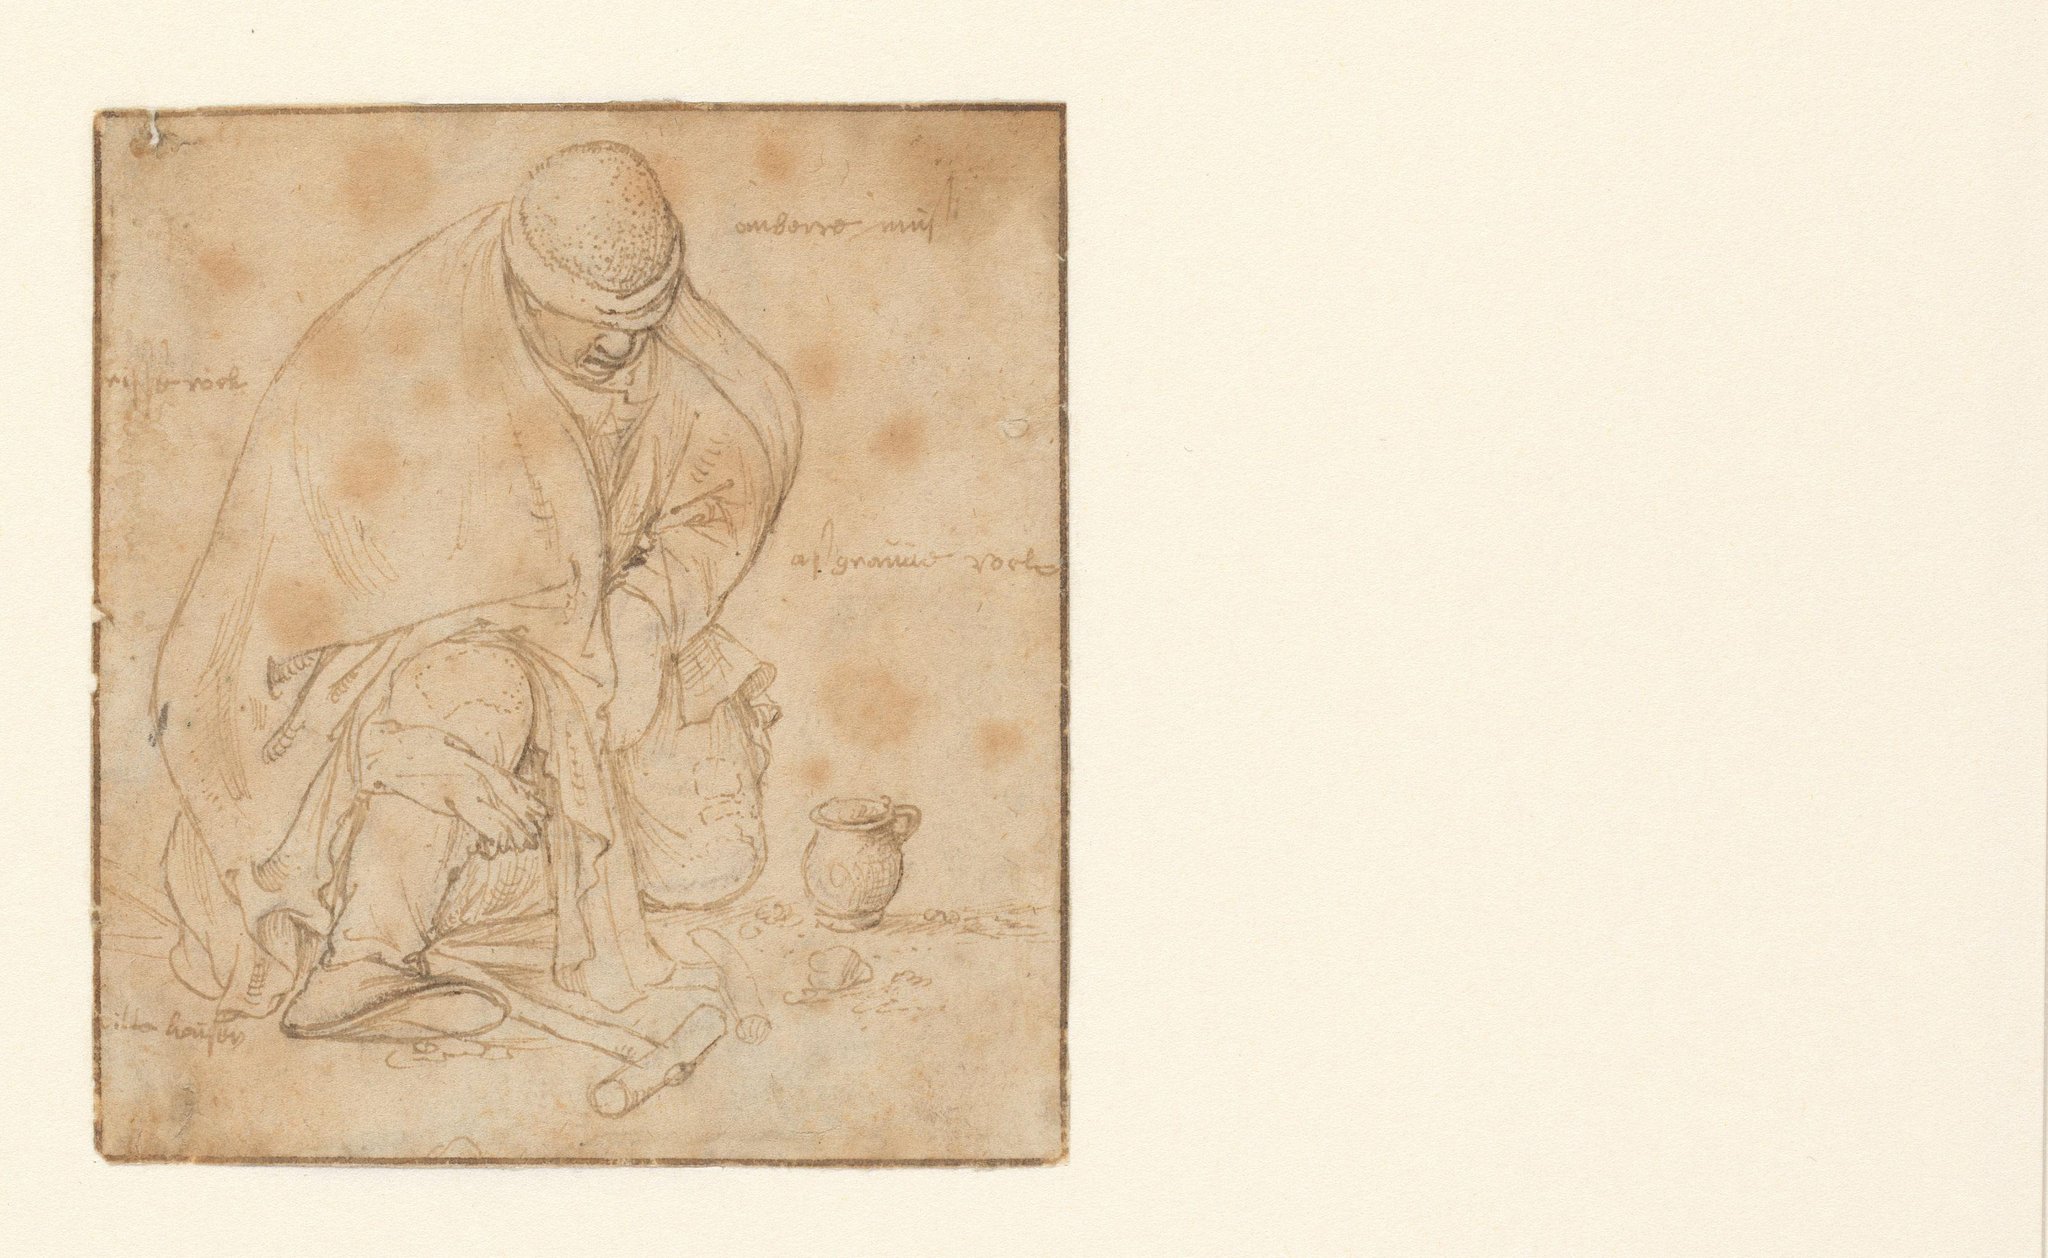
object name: drawing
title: Zittende bedelaar, in een mantel gehuld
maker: roelant savery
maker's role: draughtsman, painter, print maker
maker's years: 1576-1639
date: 1603-1613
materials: chalk, graphite, ink, paper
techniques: pen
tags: beggar